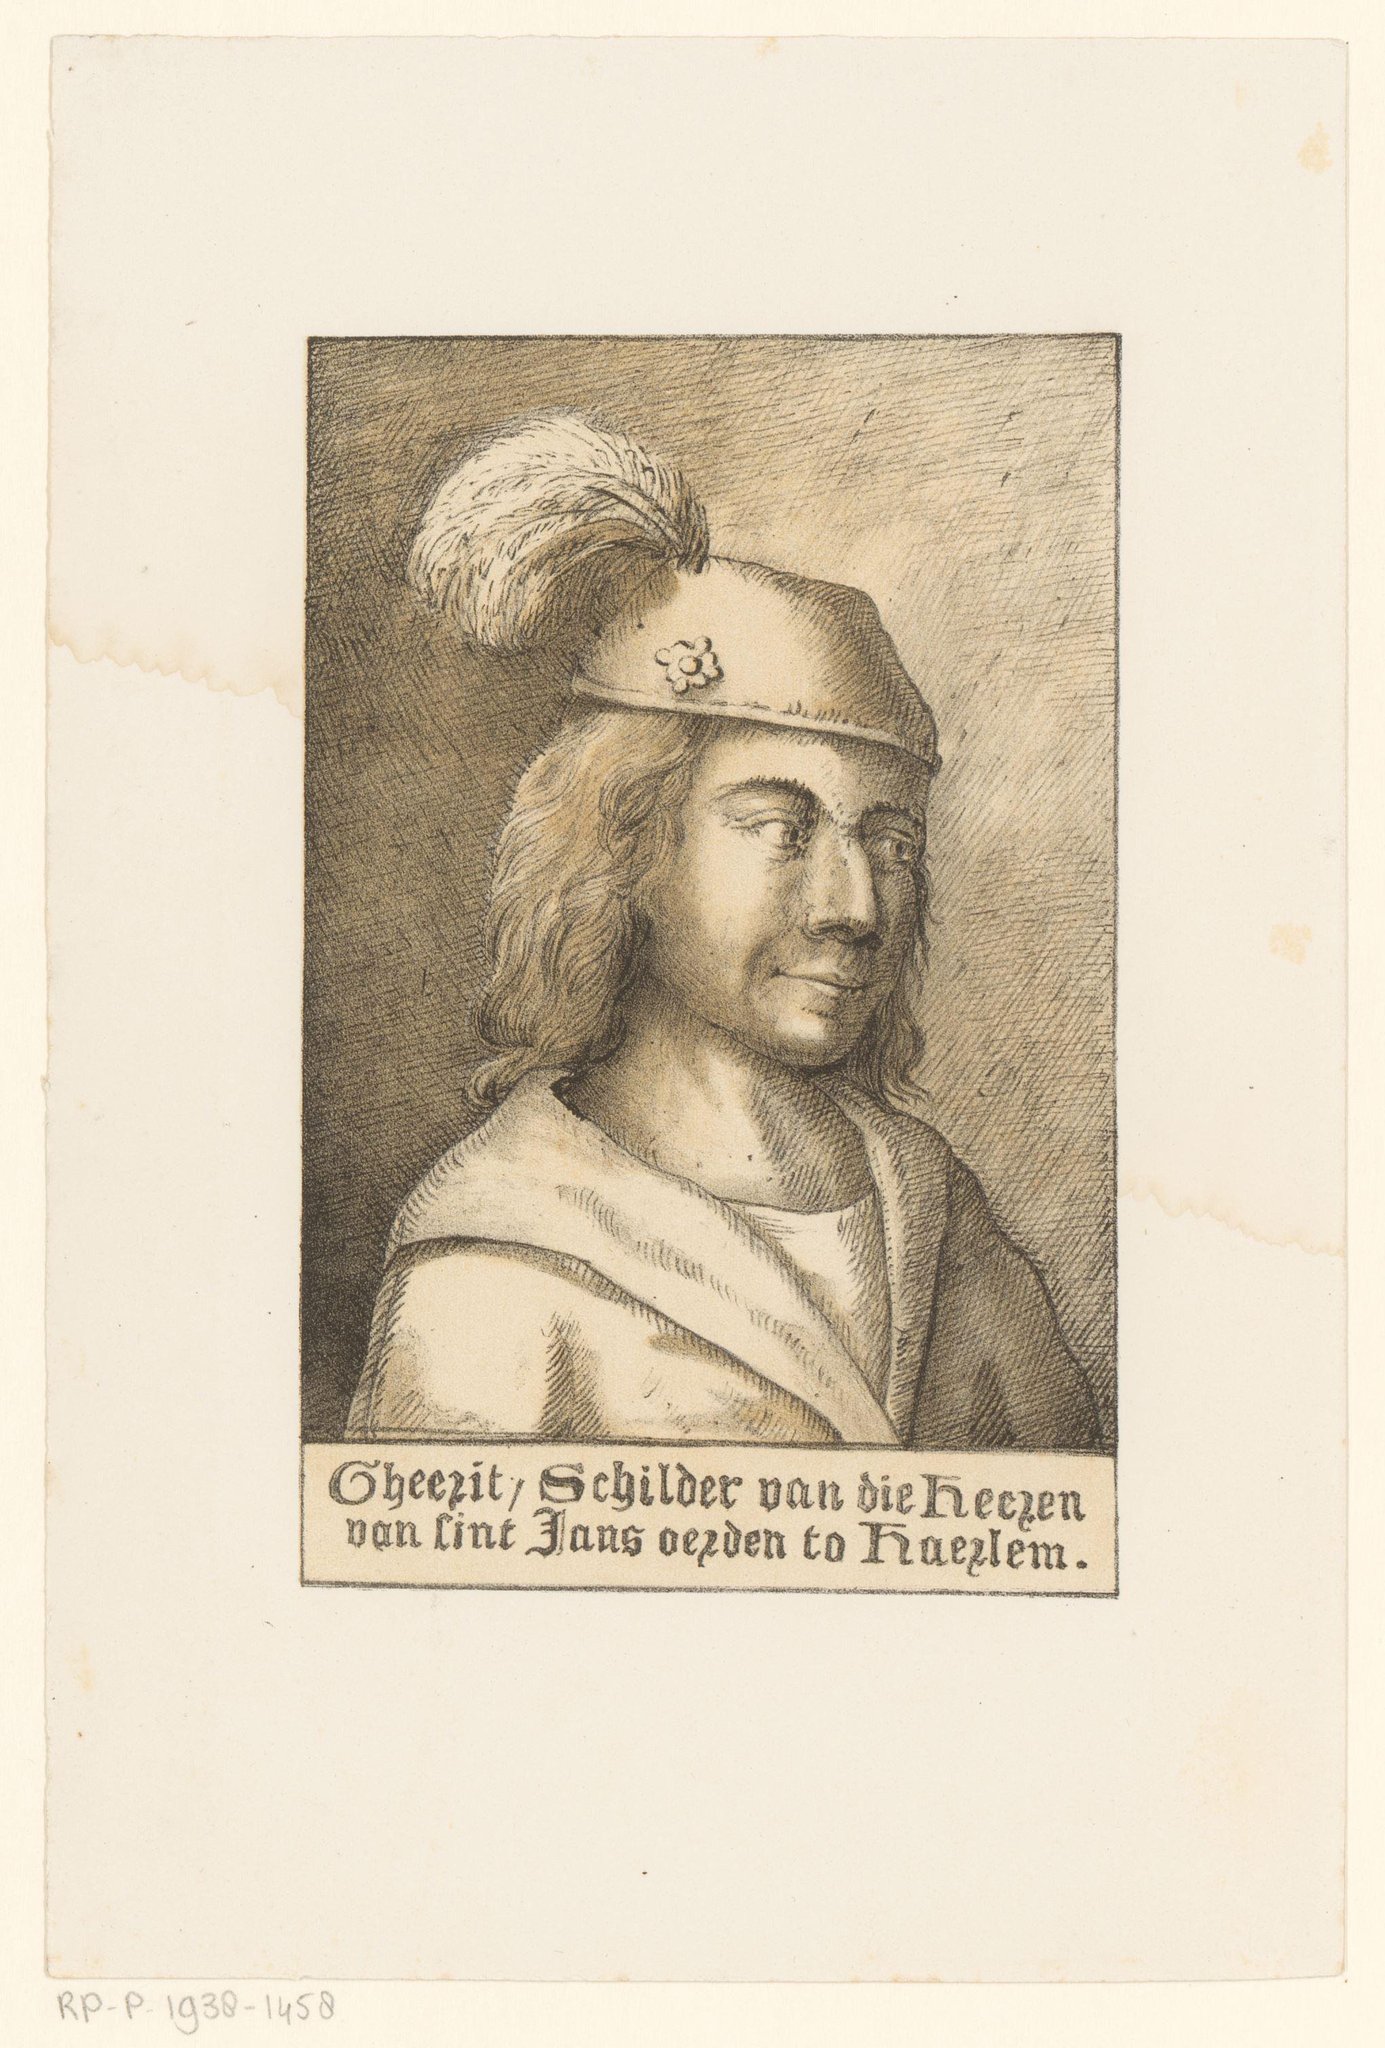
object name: print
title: Portret van Geertgen tot Sint Jans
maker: frederik hendrik weissenbruch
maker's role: draughtsman, print maker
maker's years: 1828-1887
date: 1838-1887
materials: paper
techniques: tone lithography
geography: the hague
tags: haarlem, painter, geertgen tot sint jans, historical persons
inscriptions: collector's mark: Lugt 2228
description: Diverse proefdrukken in de collectie, zie RP-P-1938-1457 t/m 1965.